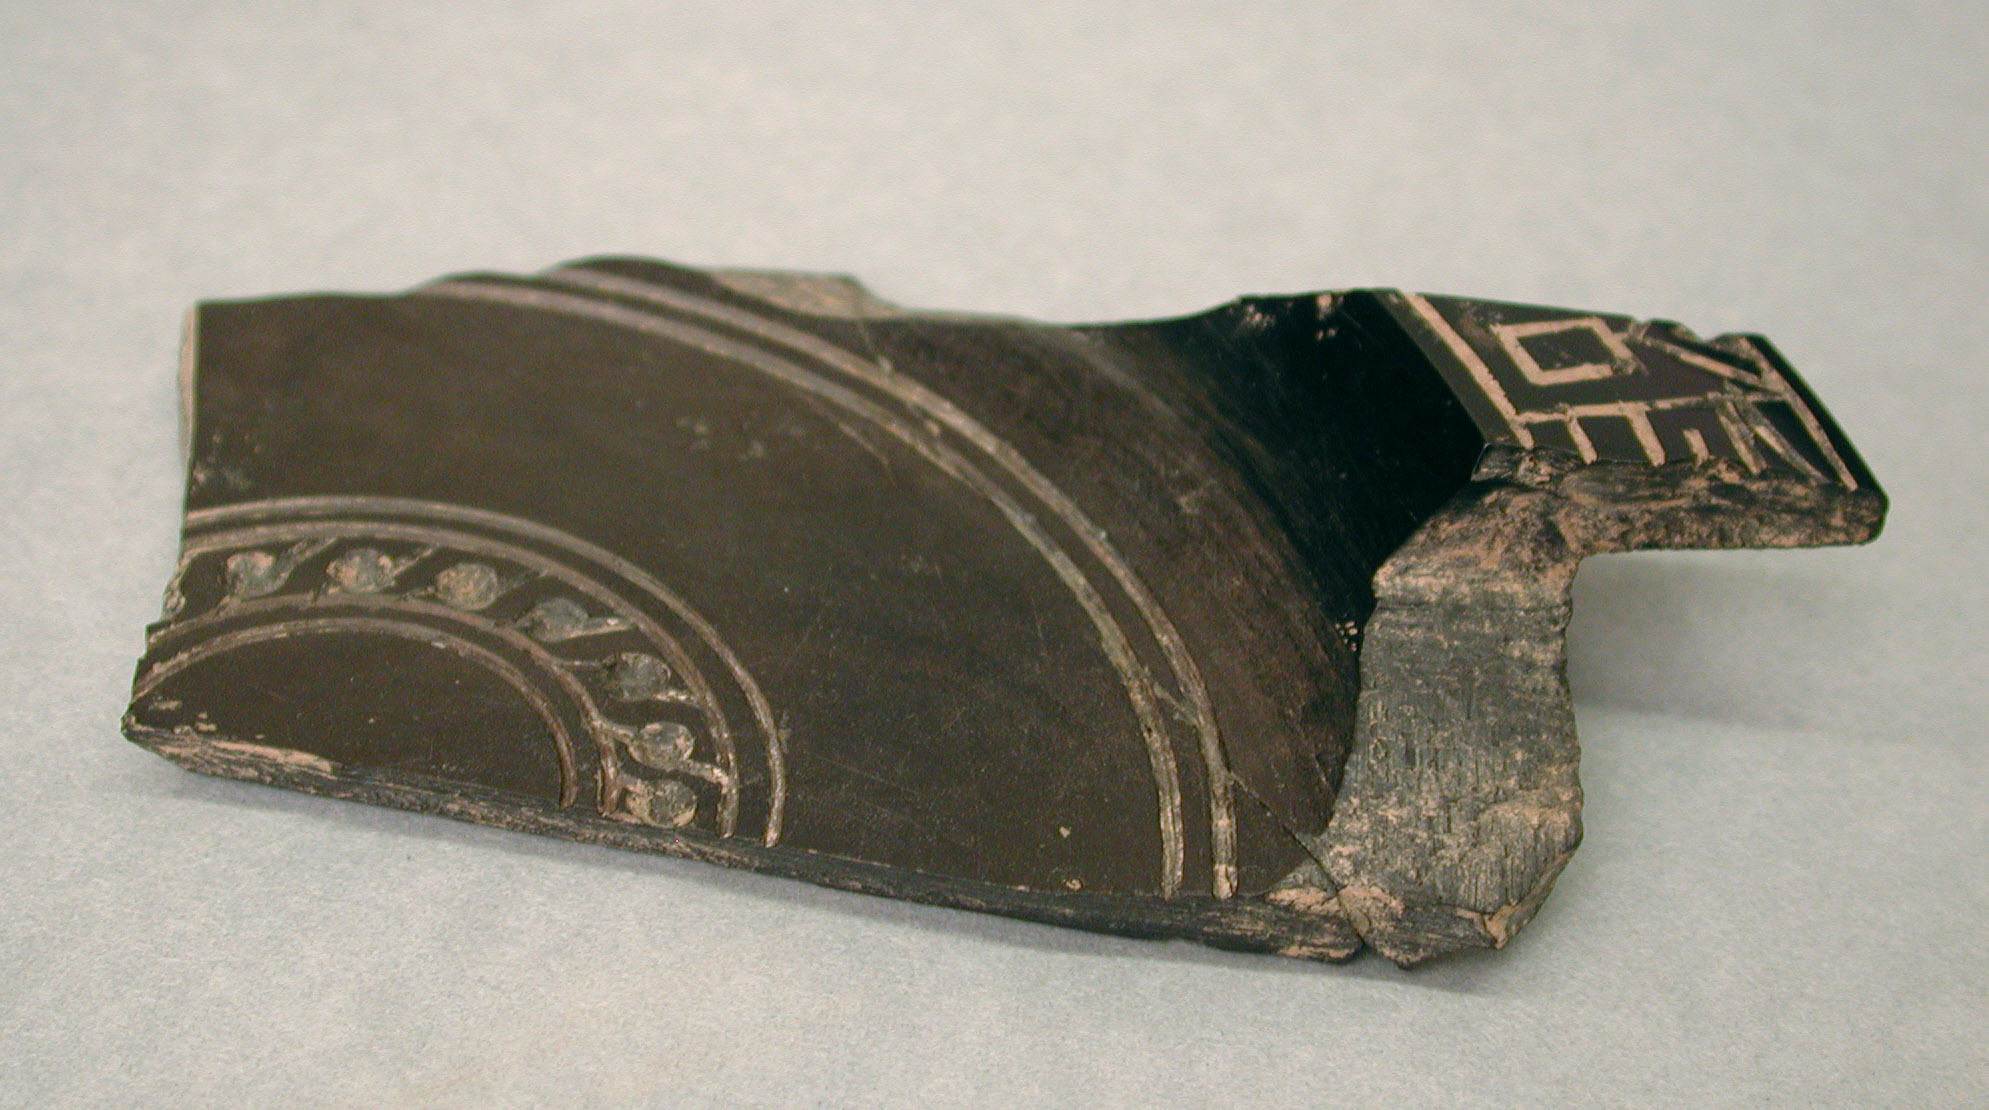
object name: fragment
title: Fragment of a Plate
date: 701-1300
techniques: incising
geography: iran